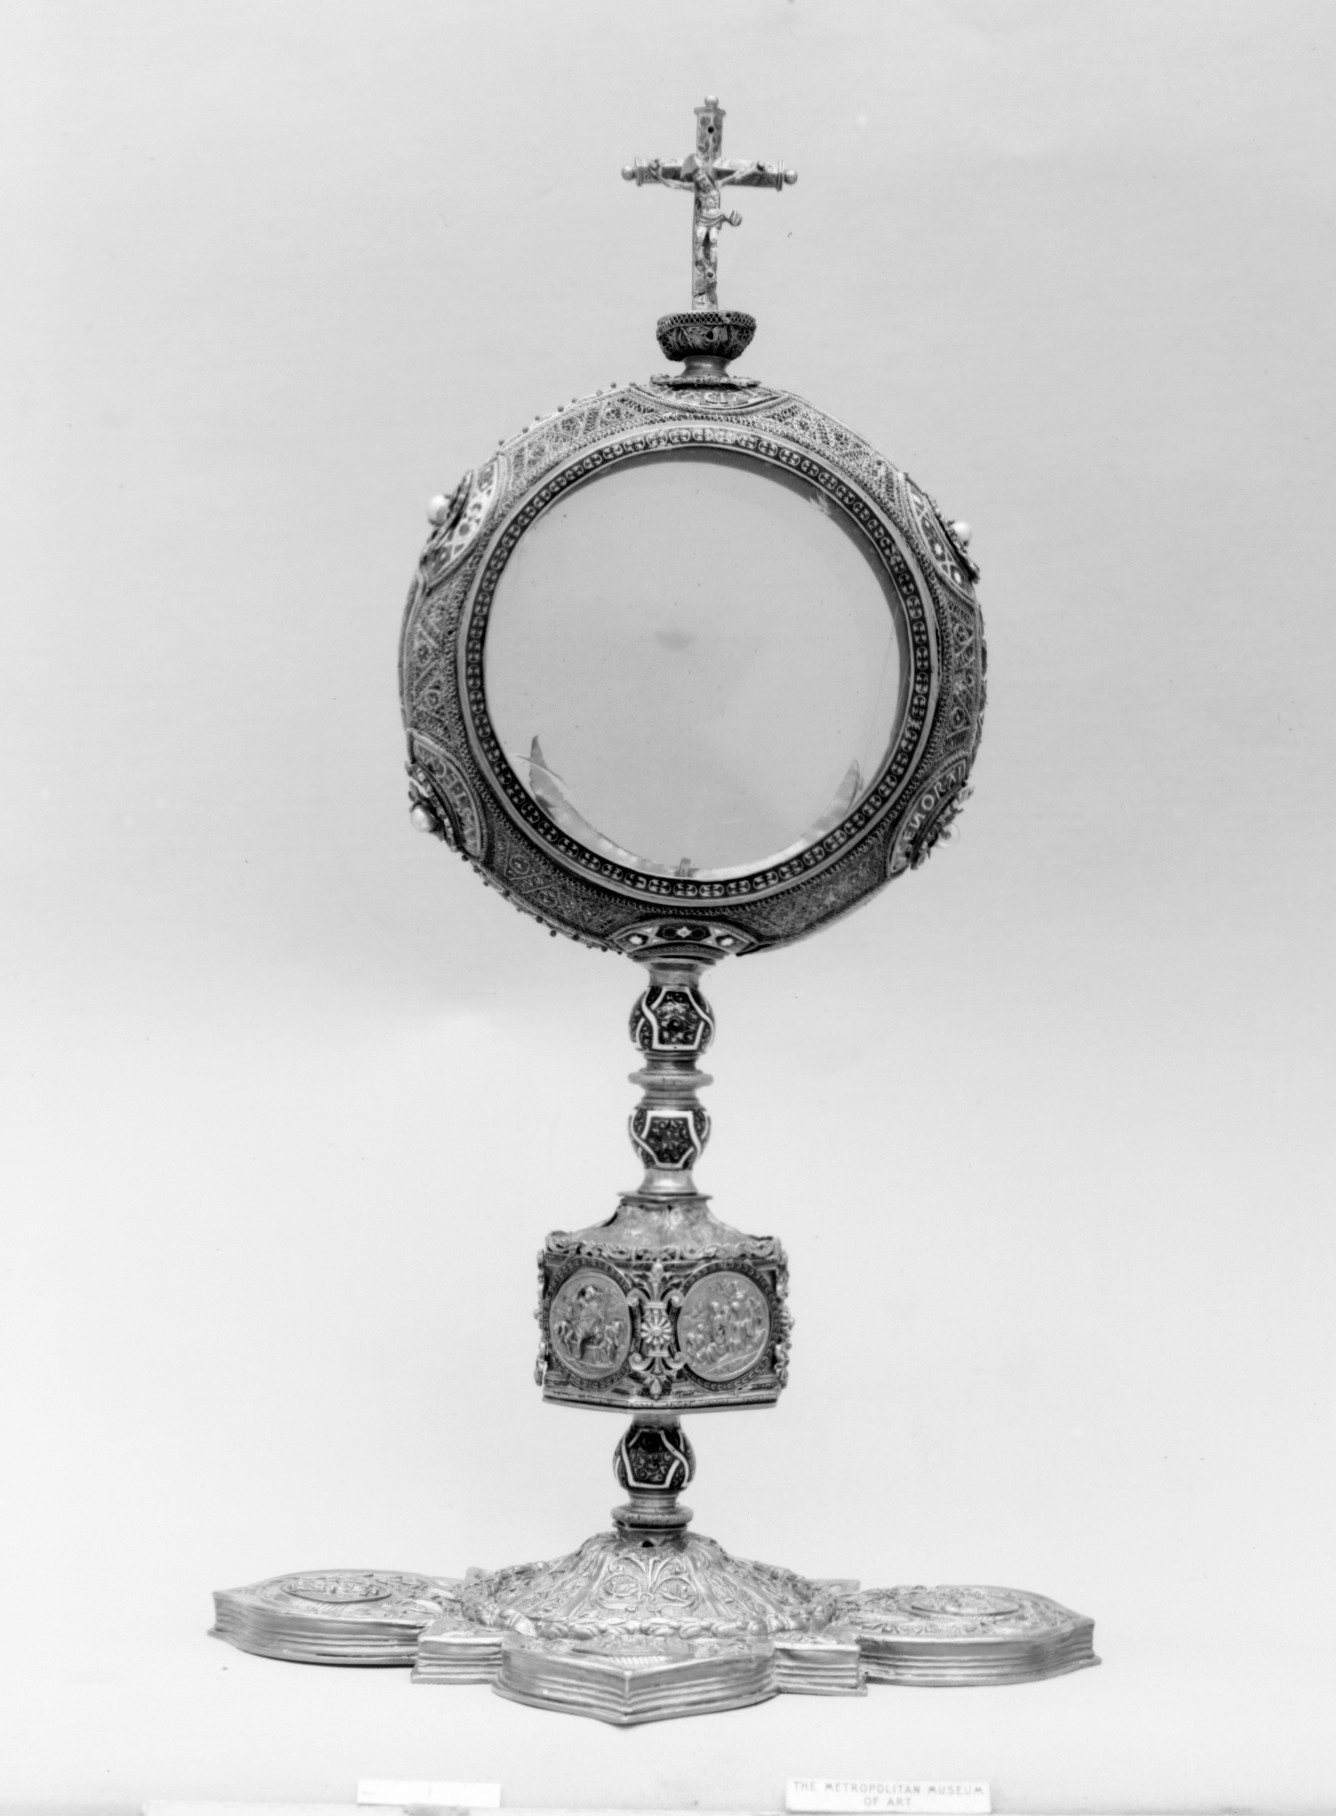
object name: monstrance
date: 1501-1700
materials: enamel, gold, pearl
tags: crucifixion